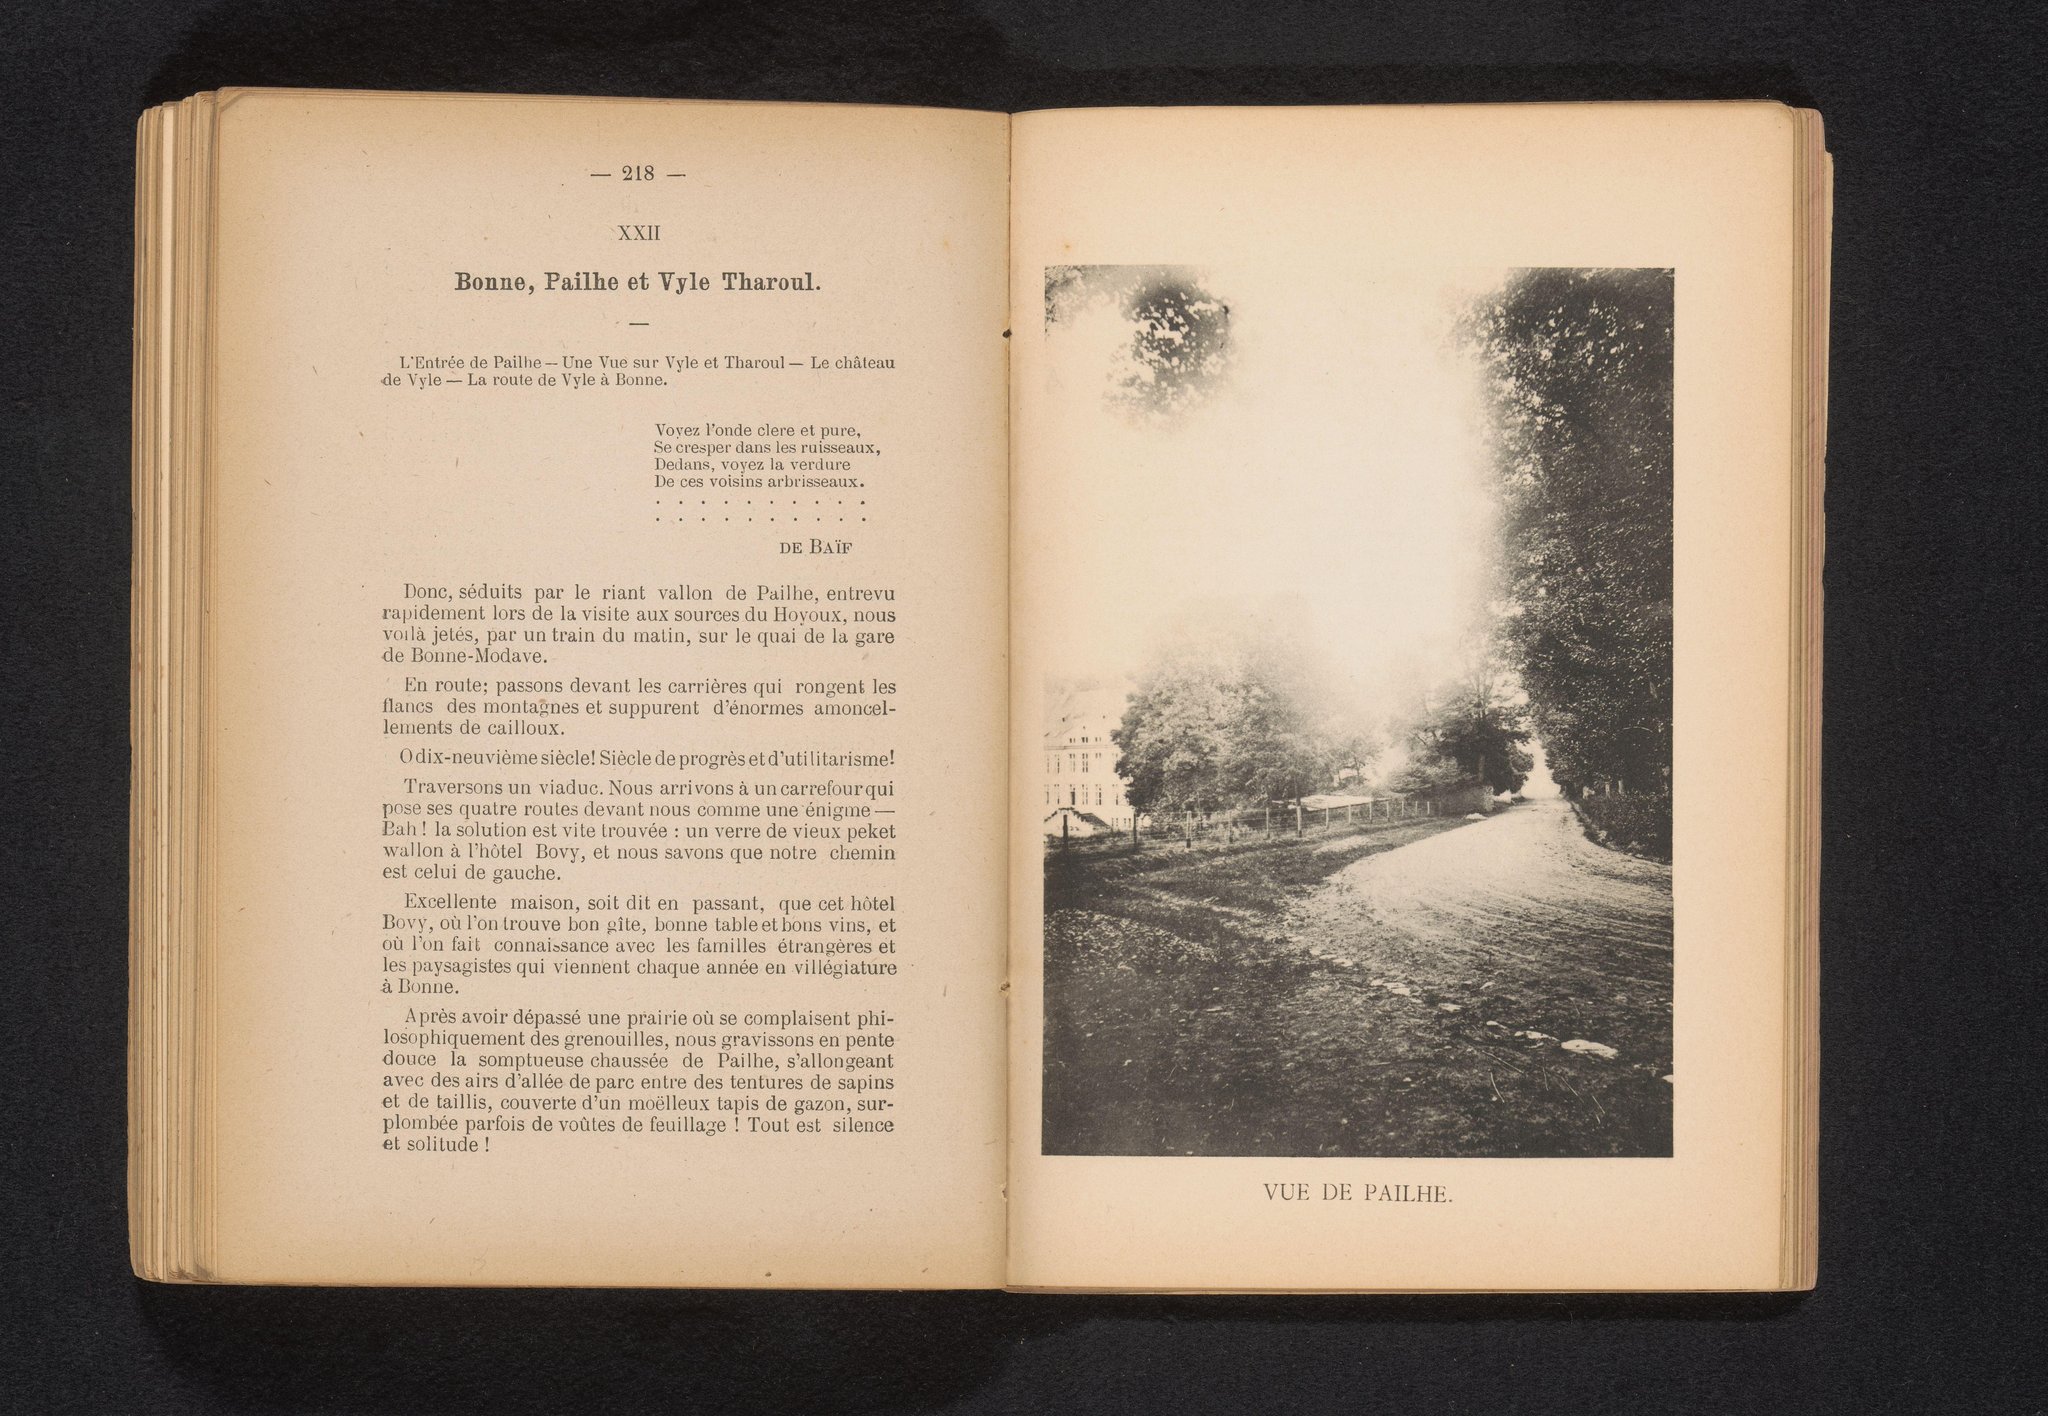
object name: page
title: Vue de Pailhe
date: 1885-1890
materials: paper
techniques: photograph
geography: pailhe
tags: castle